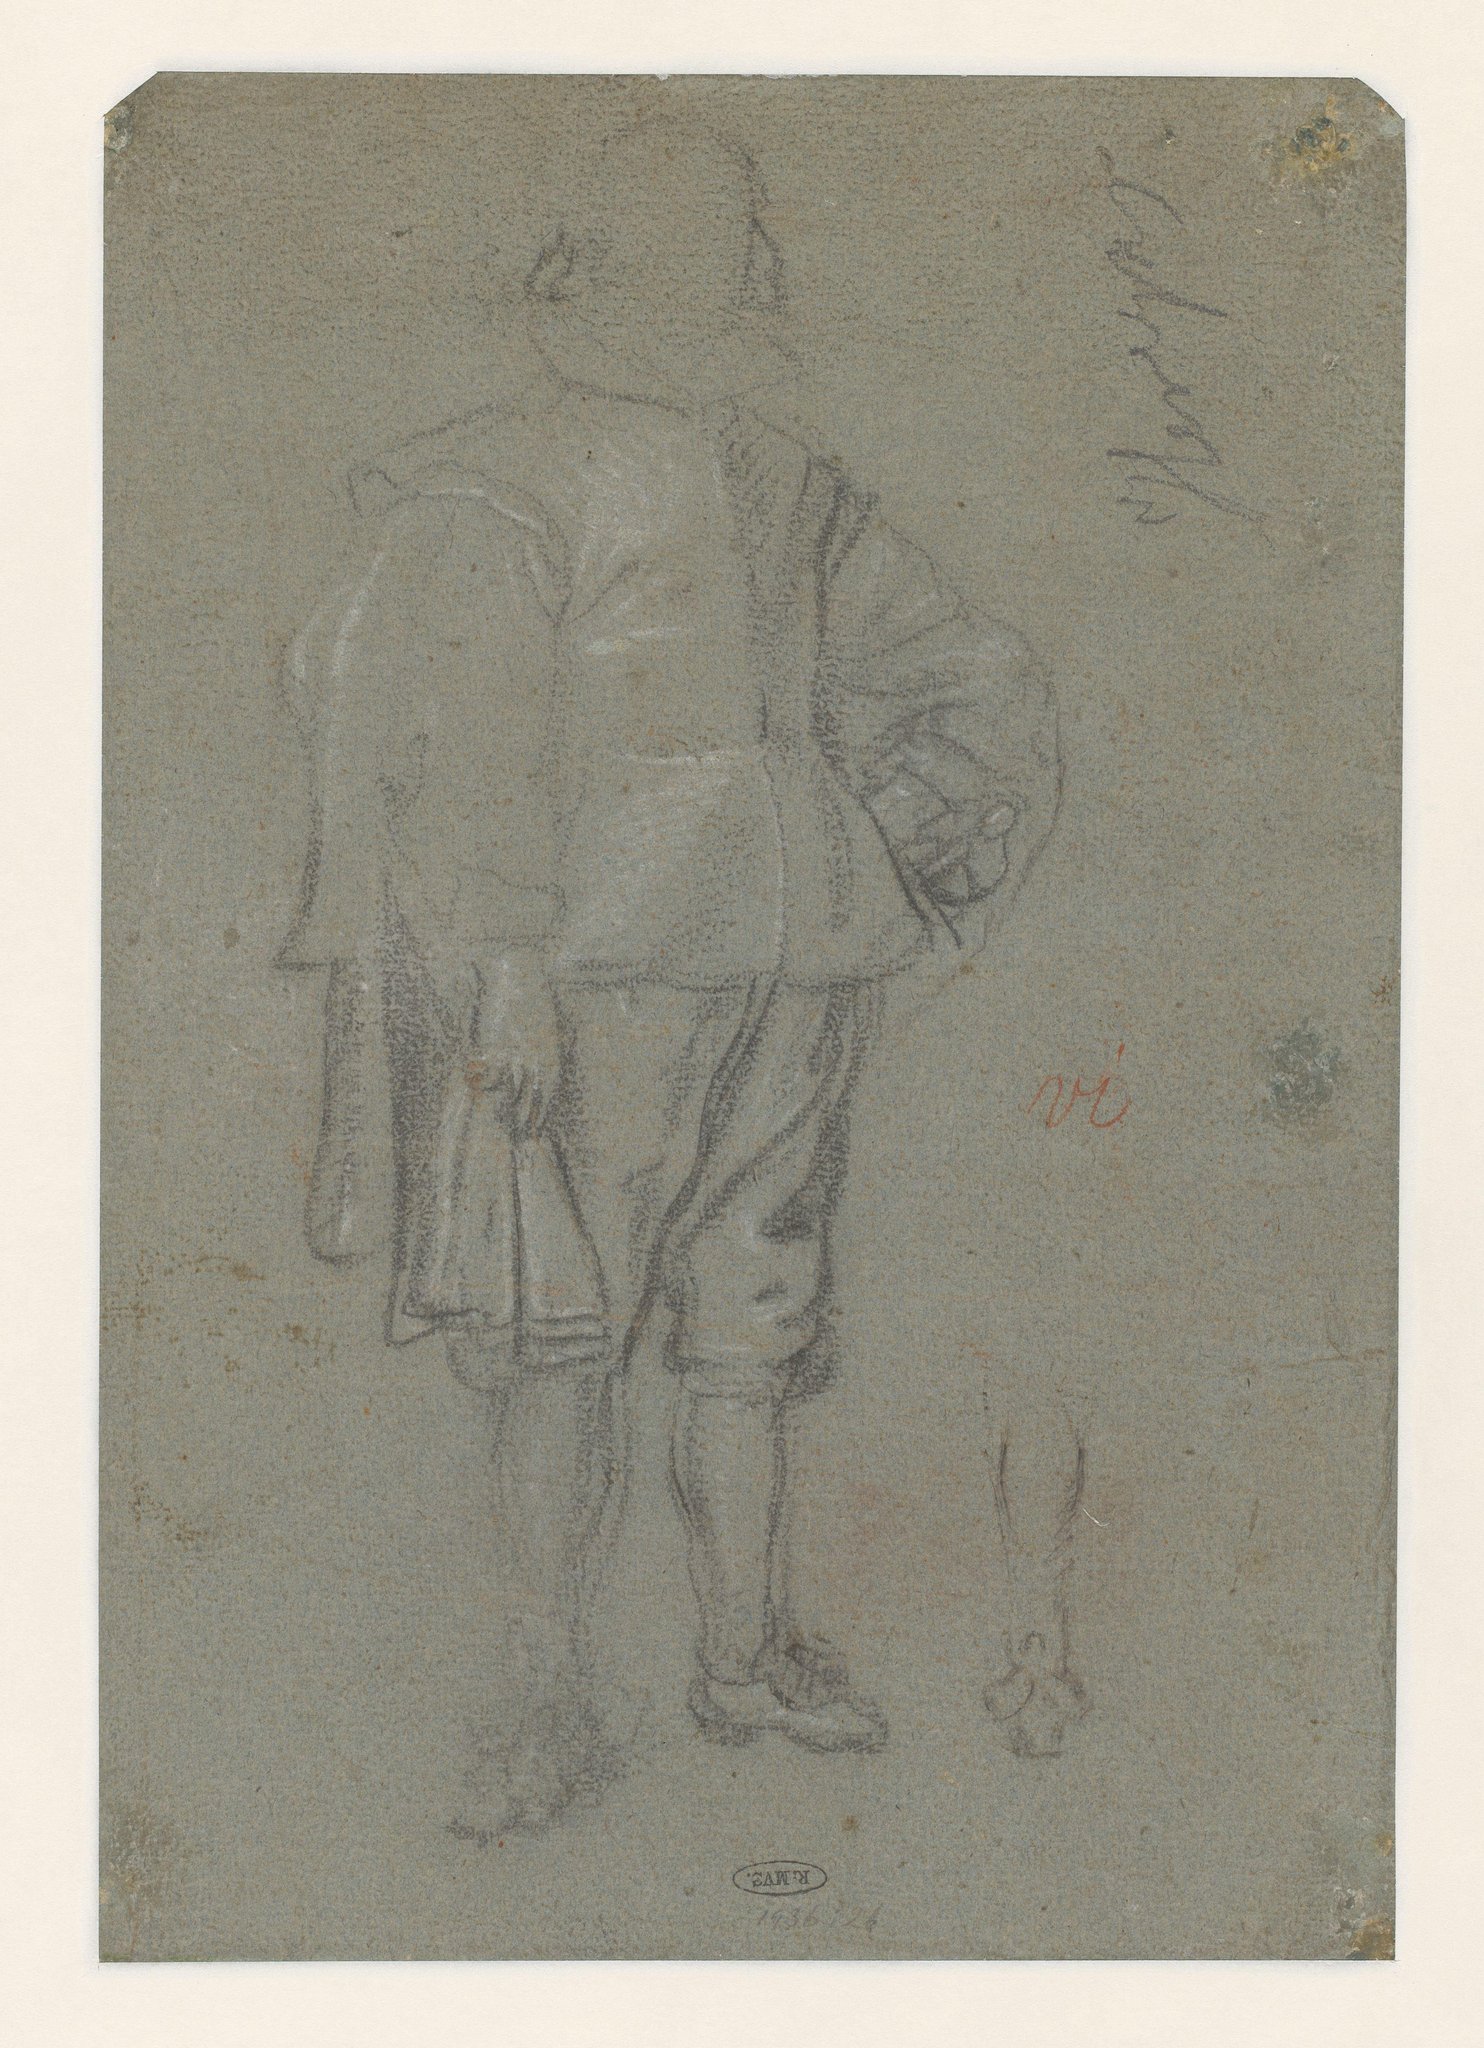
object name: drawing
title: Studie van een staande man met hoed onder de arm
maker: Anonymous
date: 1600-1699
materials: chalk, paper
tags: standing figure